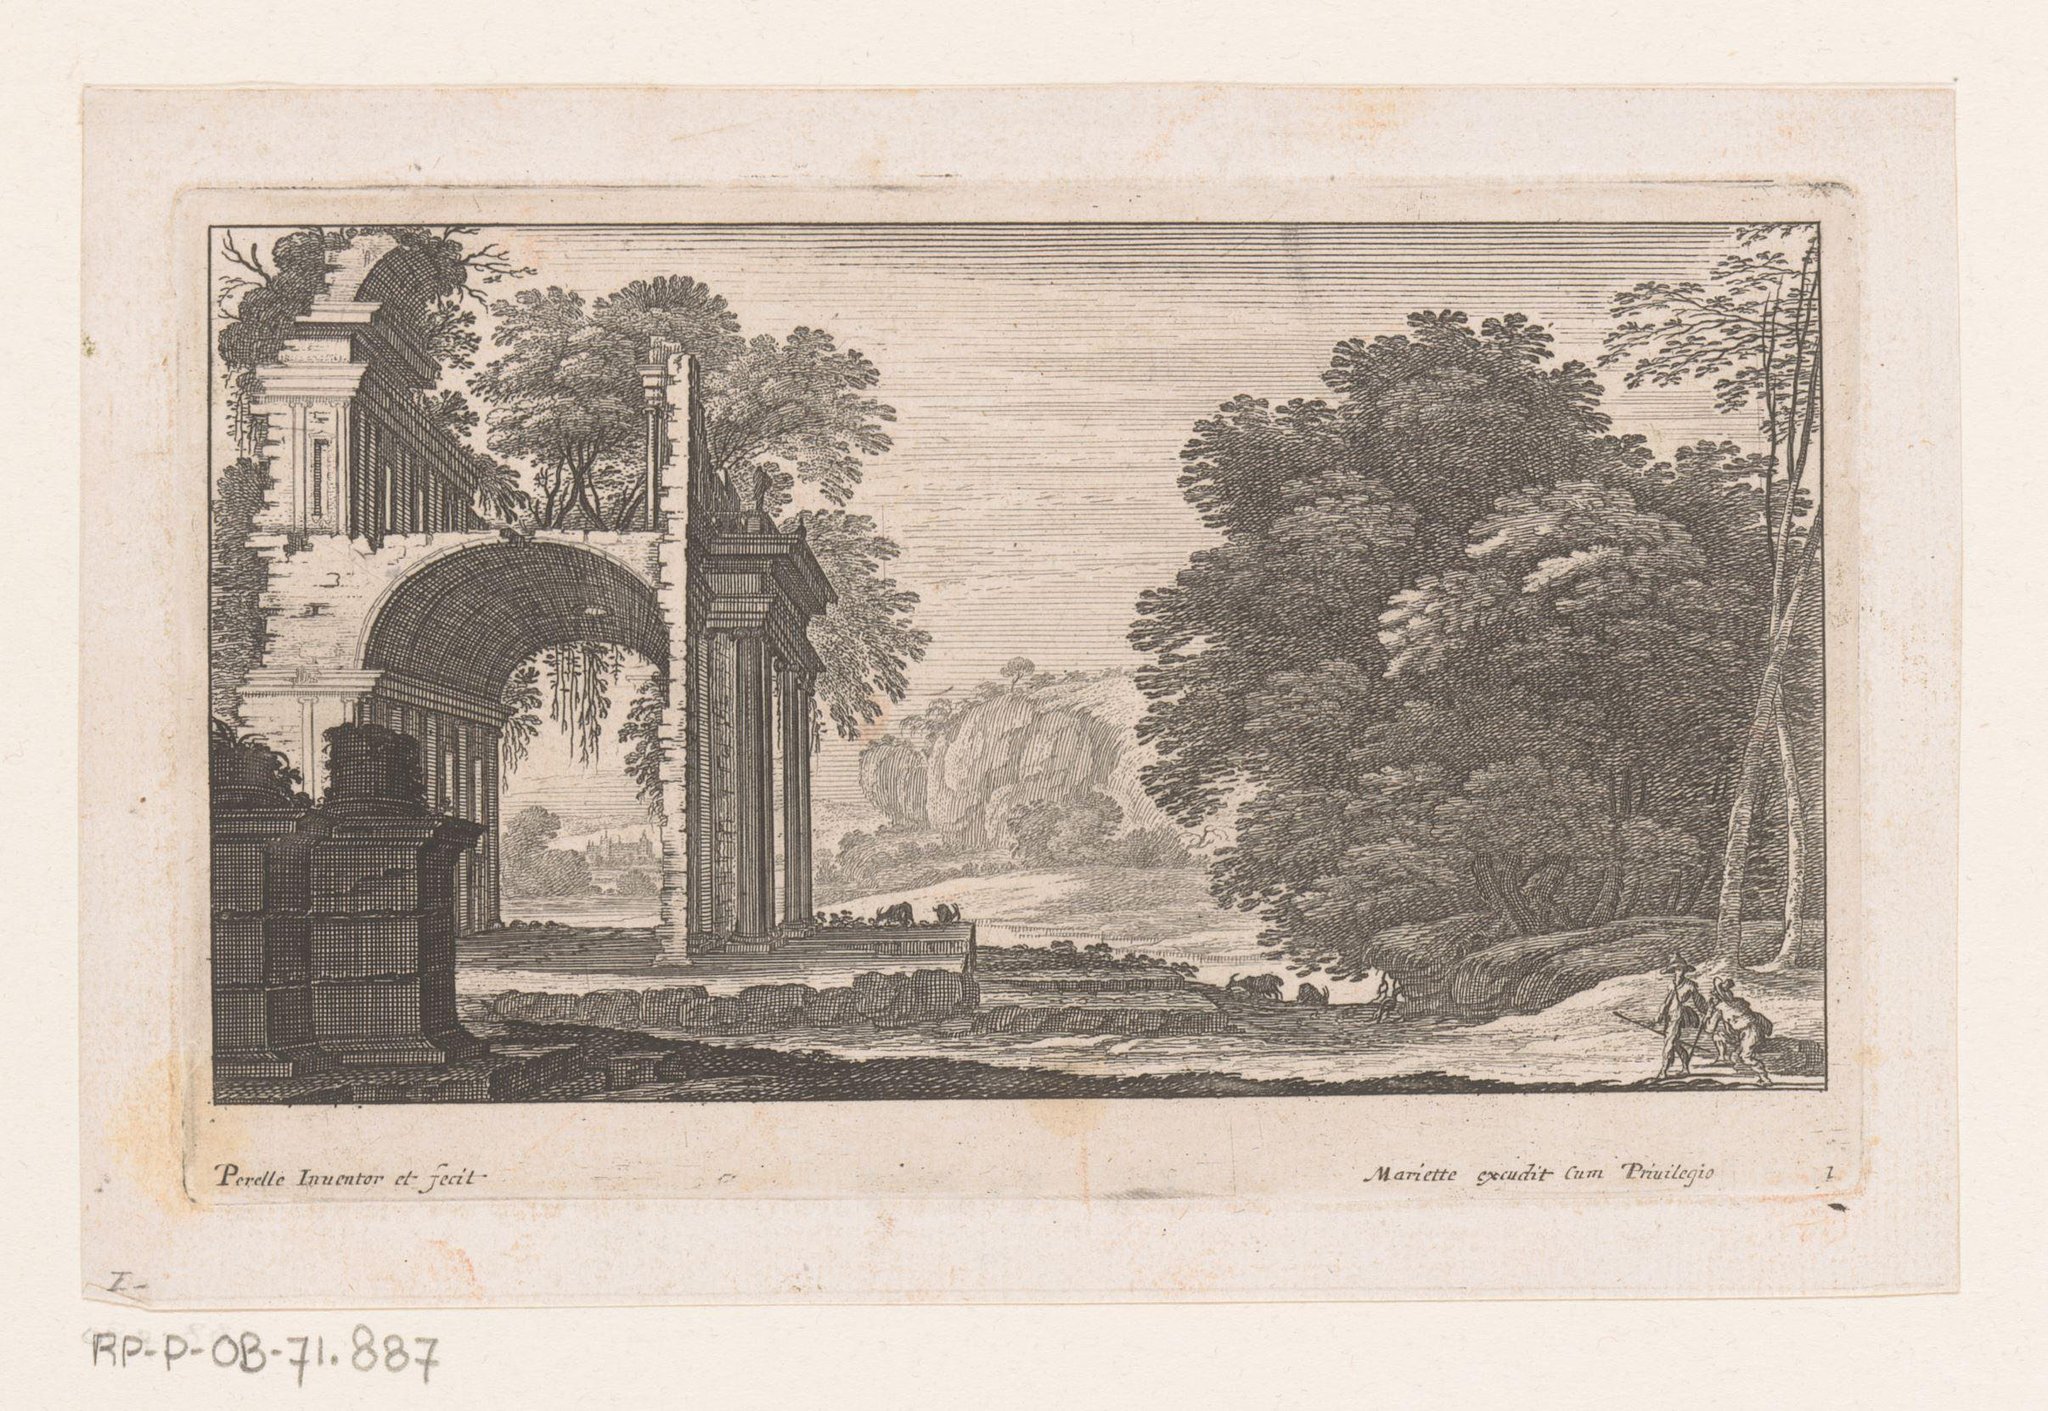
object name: print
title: Landschap met ruïne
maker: mariette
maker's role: publisher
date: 1613-1695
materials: paper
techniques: etching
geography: paris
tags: landscape with ruins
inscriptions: collector's mark: Lugt 240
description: Prenten met het signatuur 'Perelle' kunnen zowel door vader Gabriel als door zonen Nicolas en Adam gemaakt zijn.